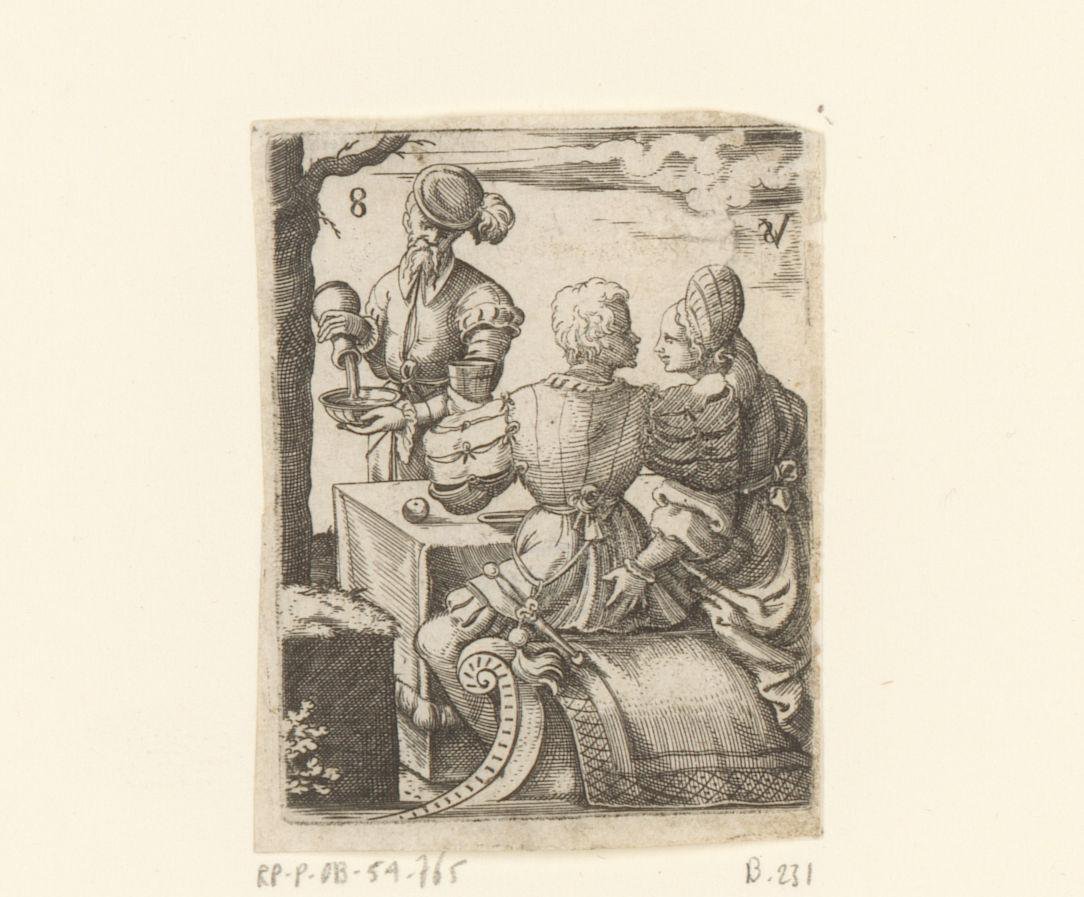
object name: print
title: Musicerende, dansende, spelende en drinkende figuren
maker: virgilius solis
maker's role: draughtsman, print maker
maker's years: 1514-1562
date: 1545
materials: paper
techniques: etching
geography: nuremberg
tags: outdoor gathering, 'délices à la campagne', alcoholic drinks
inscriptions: collector's mark: Lugt 2228, number: ‘140’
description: Prent maakt deel uit van een serie van tien prenten met musicerende, dansende, spelende en drinkende figuren.